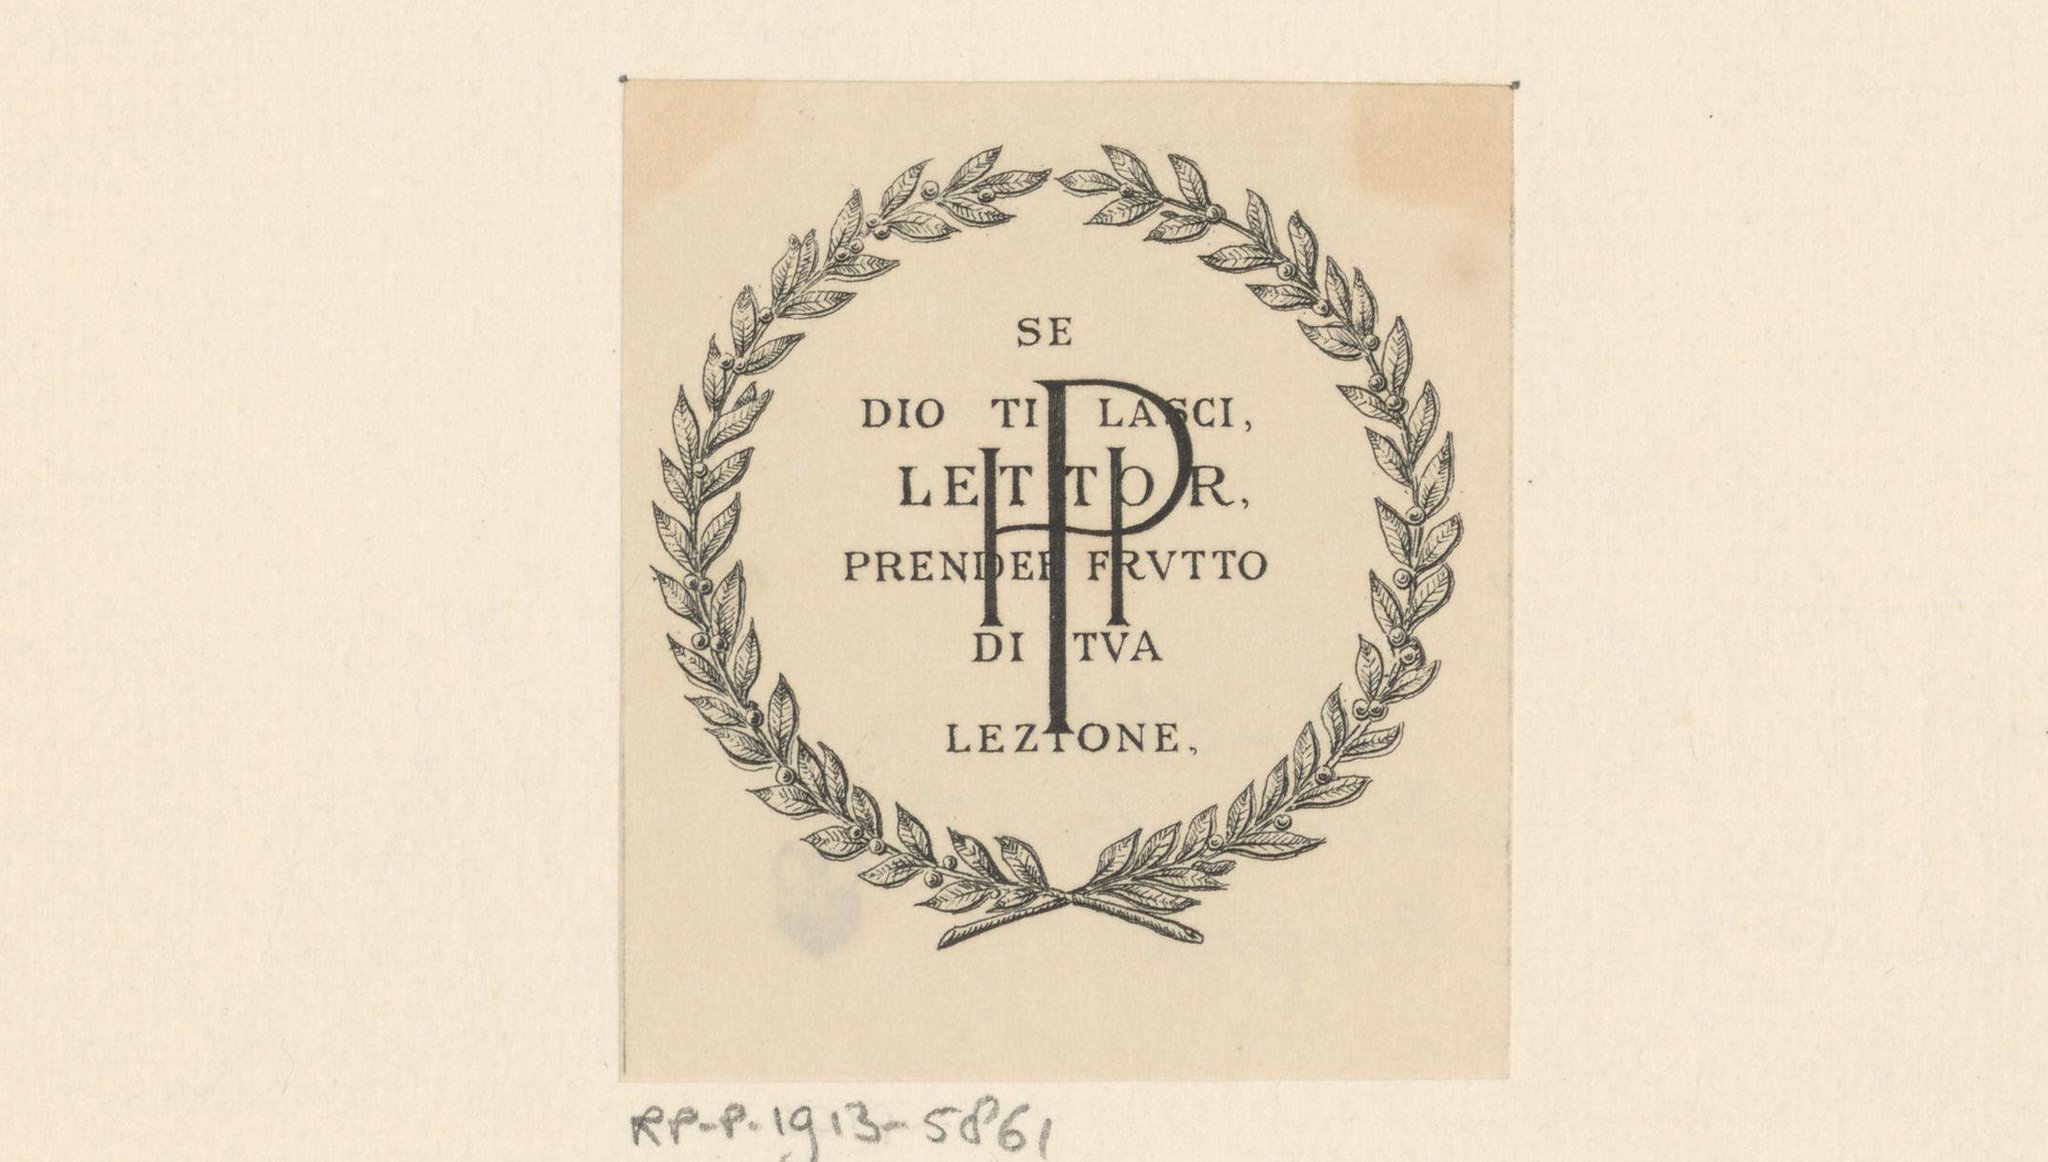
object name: bookplate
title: H.P.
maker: Anonymous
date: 1875-1913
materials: paper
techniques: etching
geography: north and central america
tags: garland, wreath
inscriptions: collector's mark: Lugt 2760, collector's mark: Lugt 2233